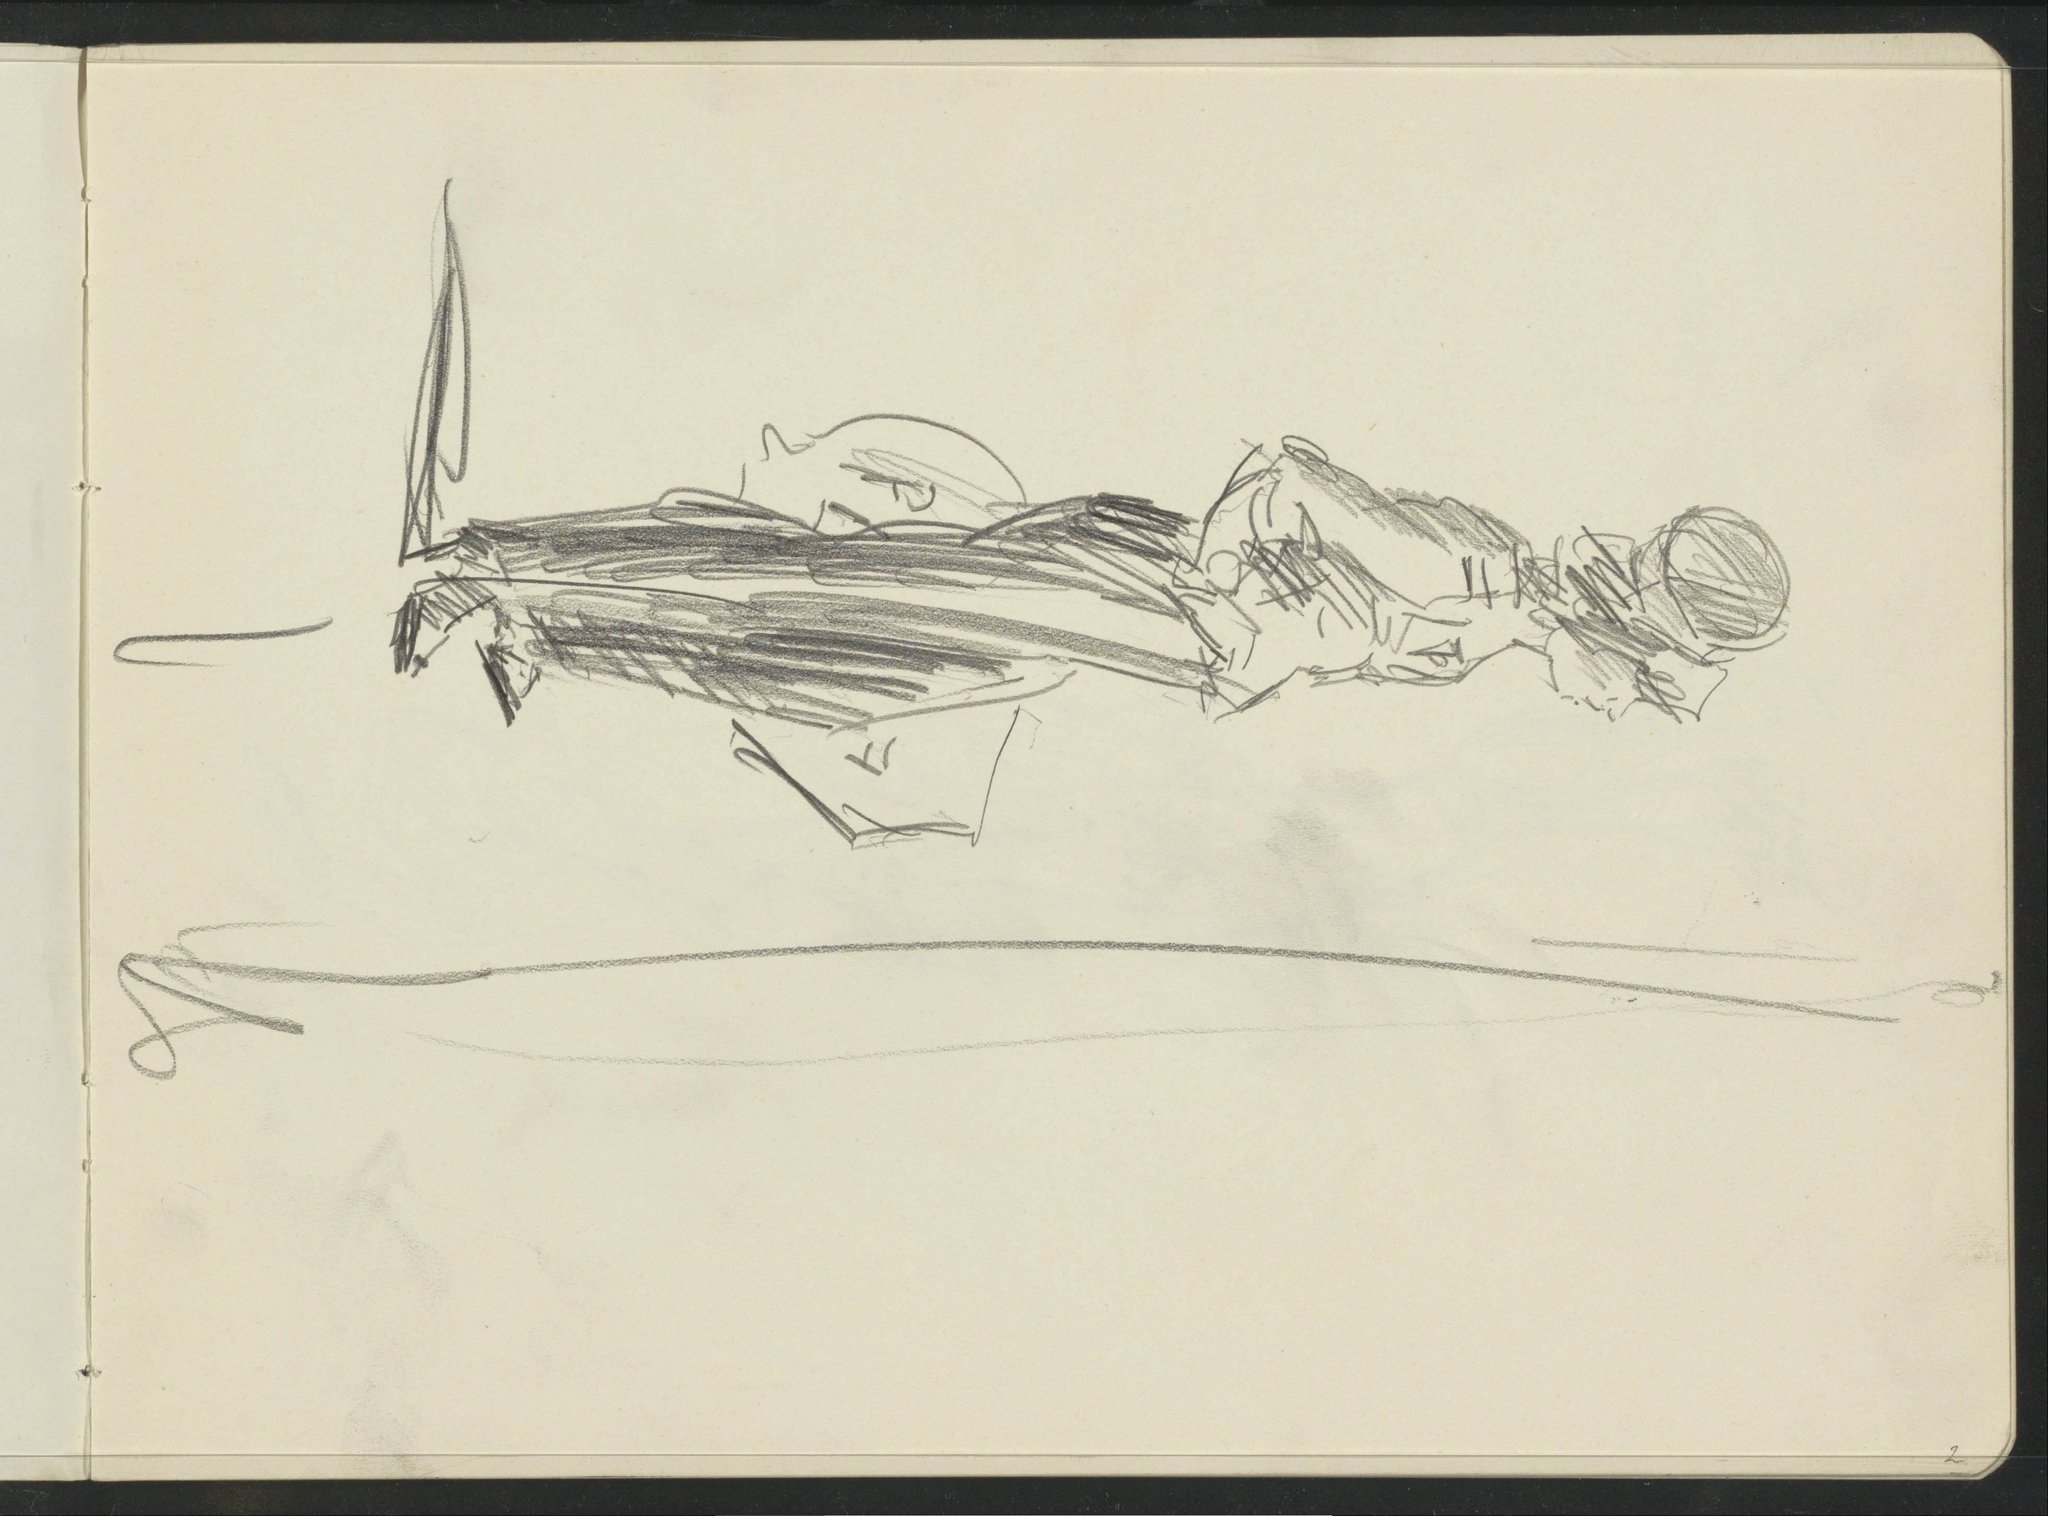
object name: sketchbook leaf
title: Staande vrouw met hoed, mogelijk een artiest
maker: isaac israels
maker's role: draughtsman, painter, print maker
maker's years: 1865-1934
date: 1915-1934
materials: paper, pencil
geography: the hague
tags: performer, artiste (non-work situations), adult woman (+ sideview, profile)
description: Haar rechterhand in haar zij en in haar linkerhand heeft ze een voorwerp. Blad 2 recto uit schetsboek XVIII met 35 bladen.